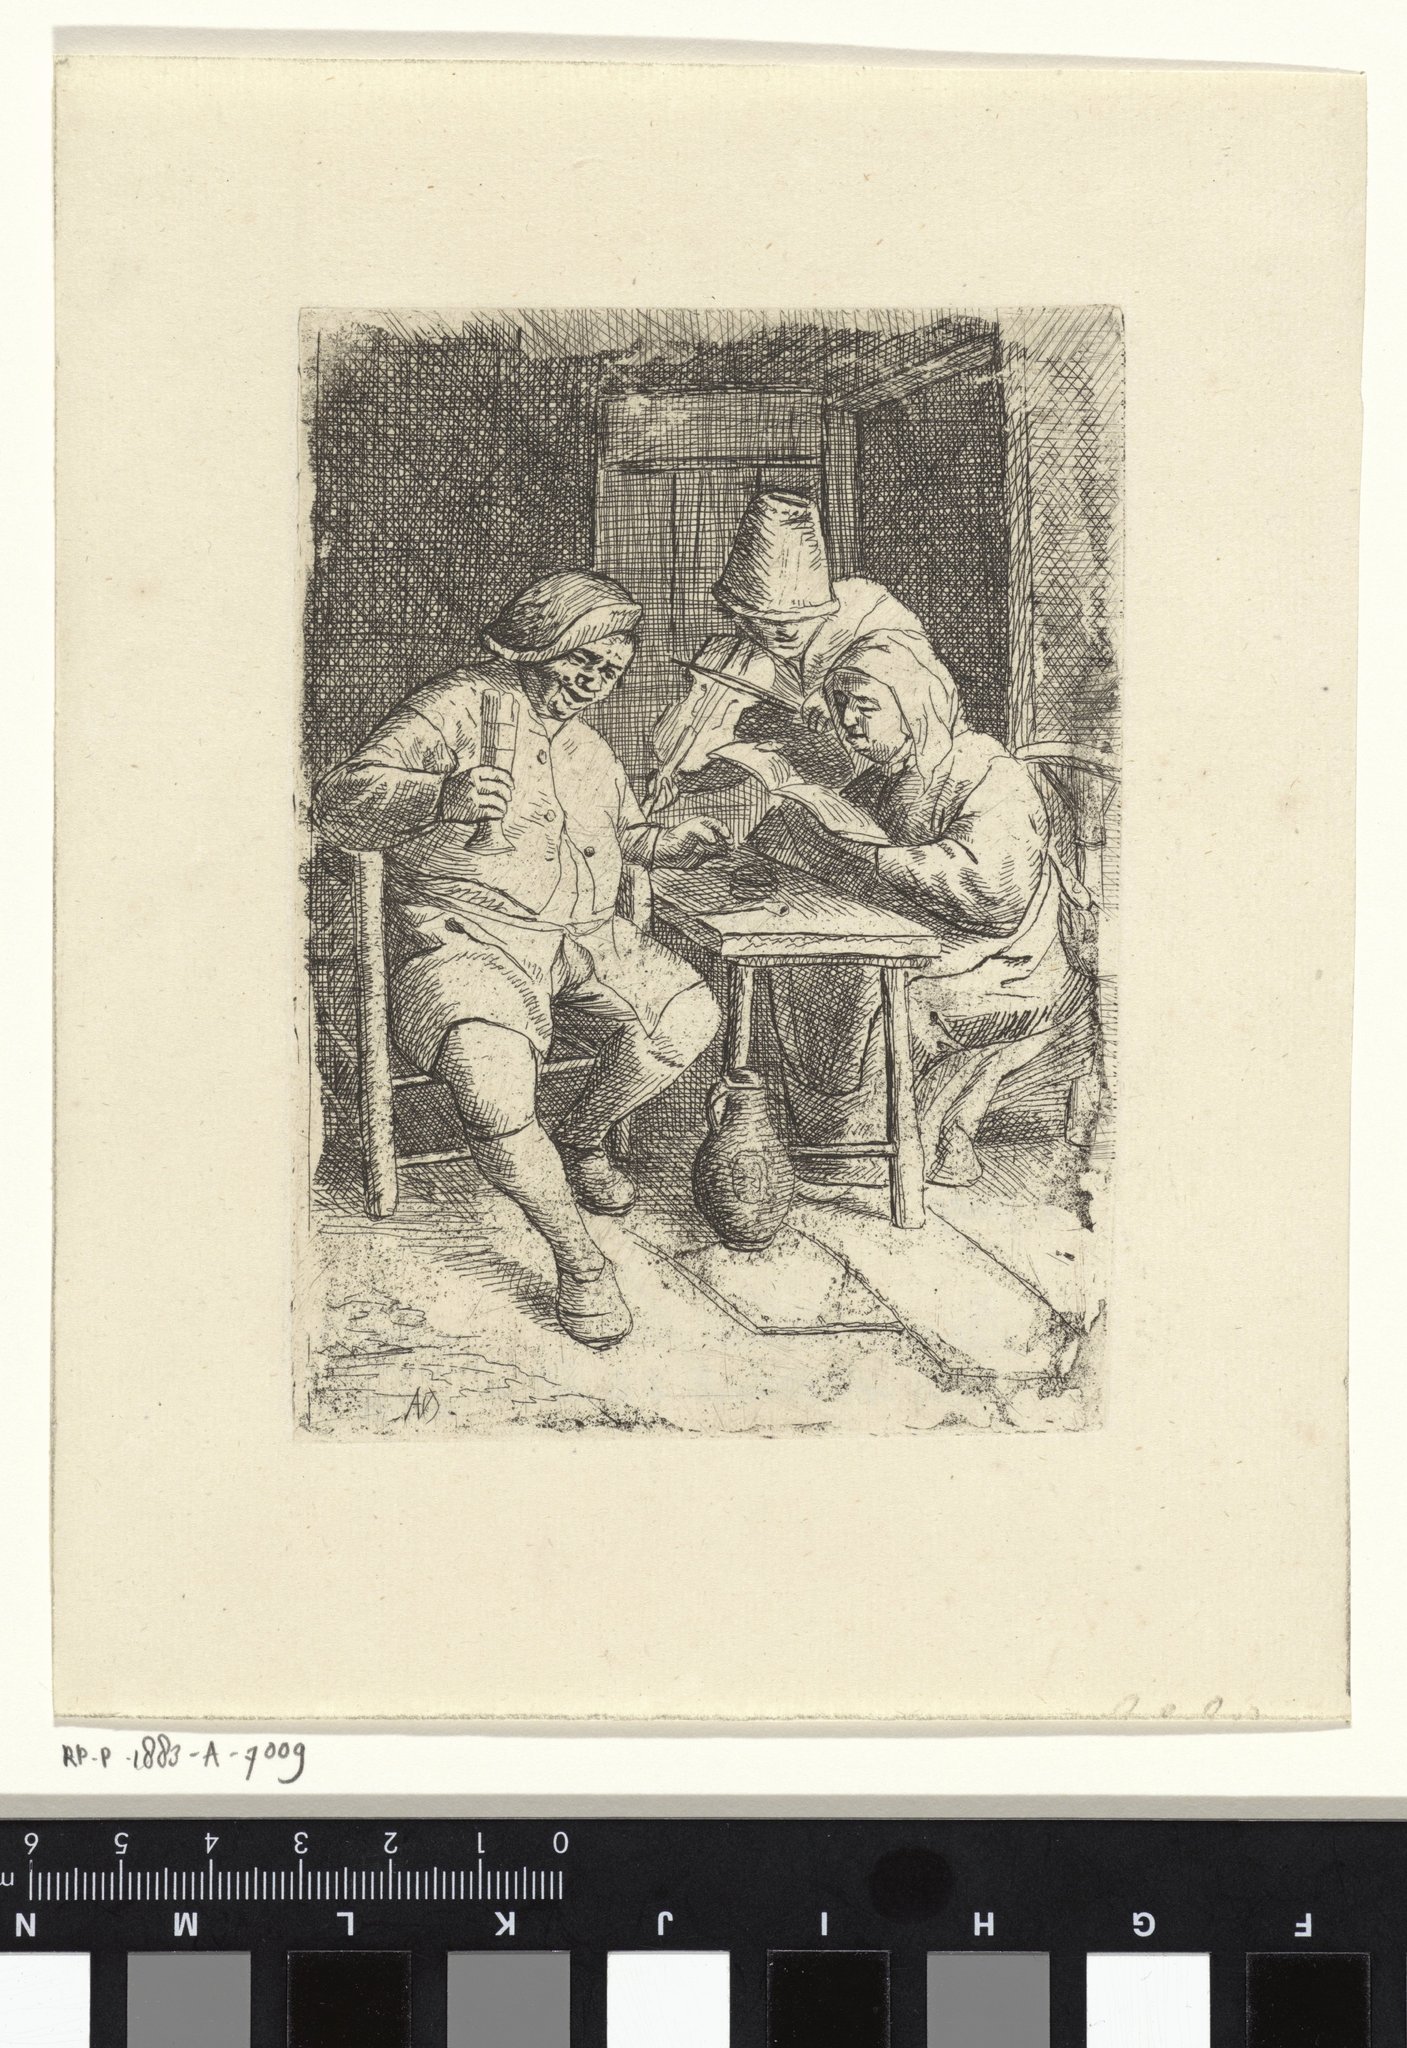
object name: print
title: Zingende vrouw en een violist bij een drinker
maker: jacob laurensz. van der vinne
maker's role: print maker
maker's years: 1688-1737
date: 1699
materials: paper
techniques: etching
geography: haarlem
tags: violin, fiddle (+ artist at work), vocal music, singing, glass, rummer, container of ceramics: jar, jug, pot, vase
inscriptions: collector's mark: Lugt 2228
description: Achter een tafel in een interieur zit een vrouw, die uit een liedboek zingt. Naast haar staat een man die een viool bespeelt. Voor de tafel zit een man met een glas in de hand. Op de grond staat een kruik.